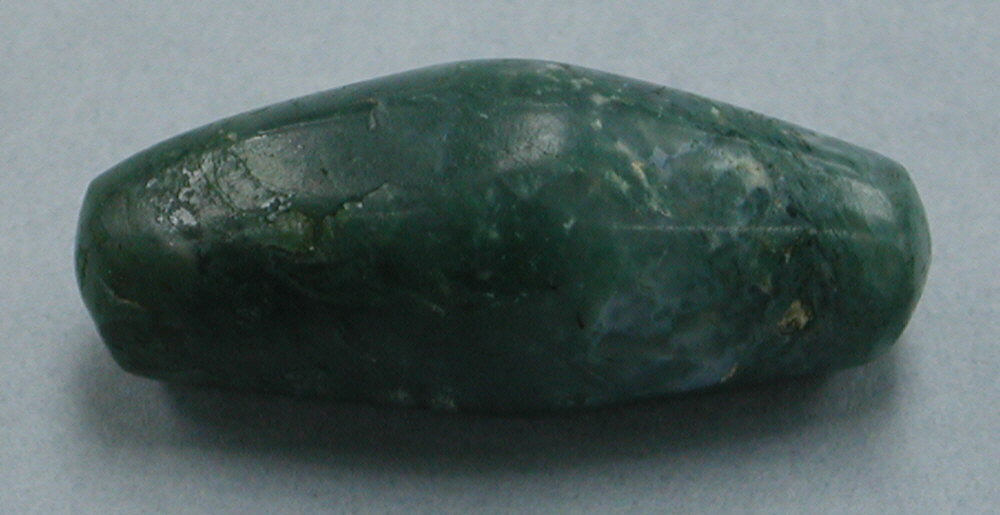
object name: ritual stone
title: Stone Pulidor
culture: mexican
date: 1501-1600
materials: stone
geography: mexico